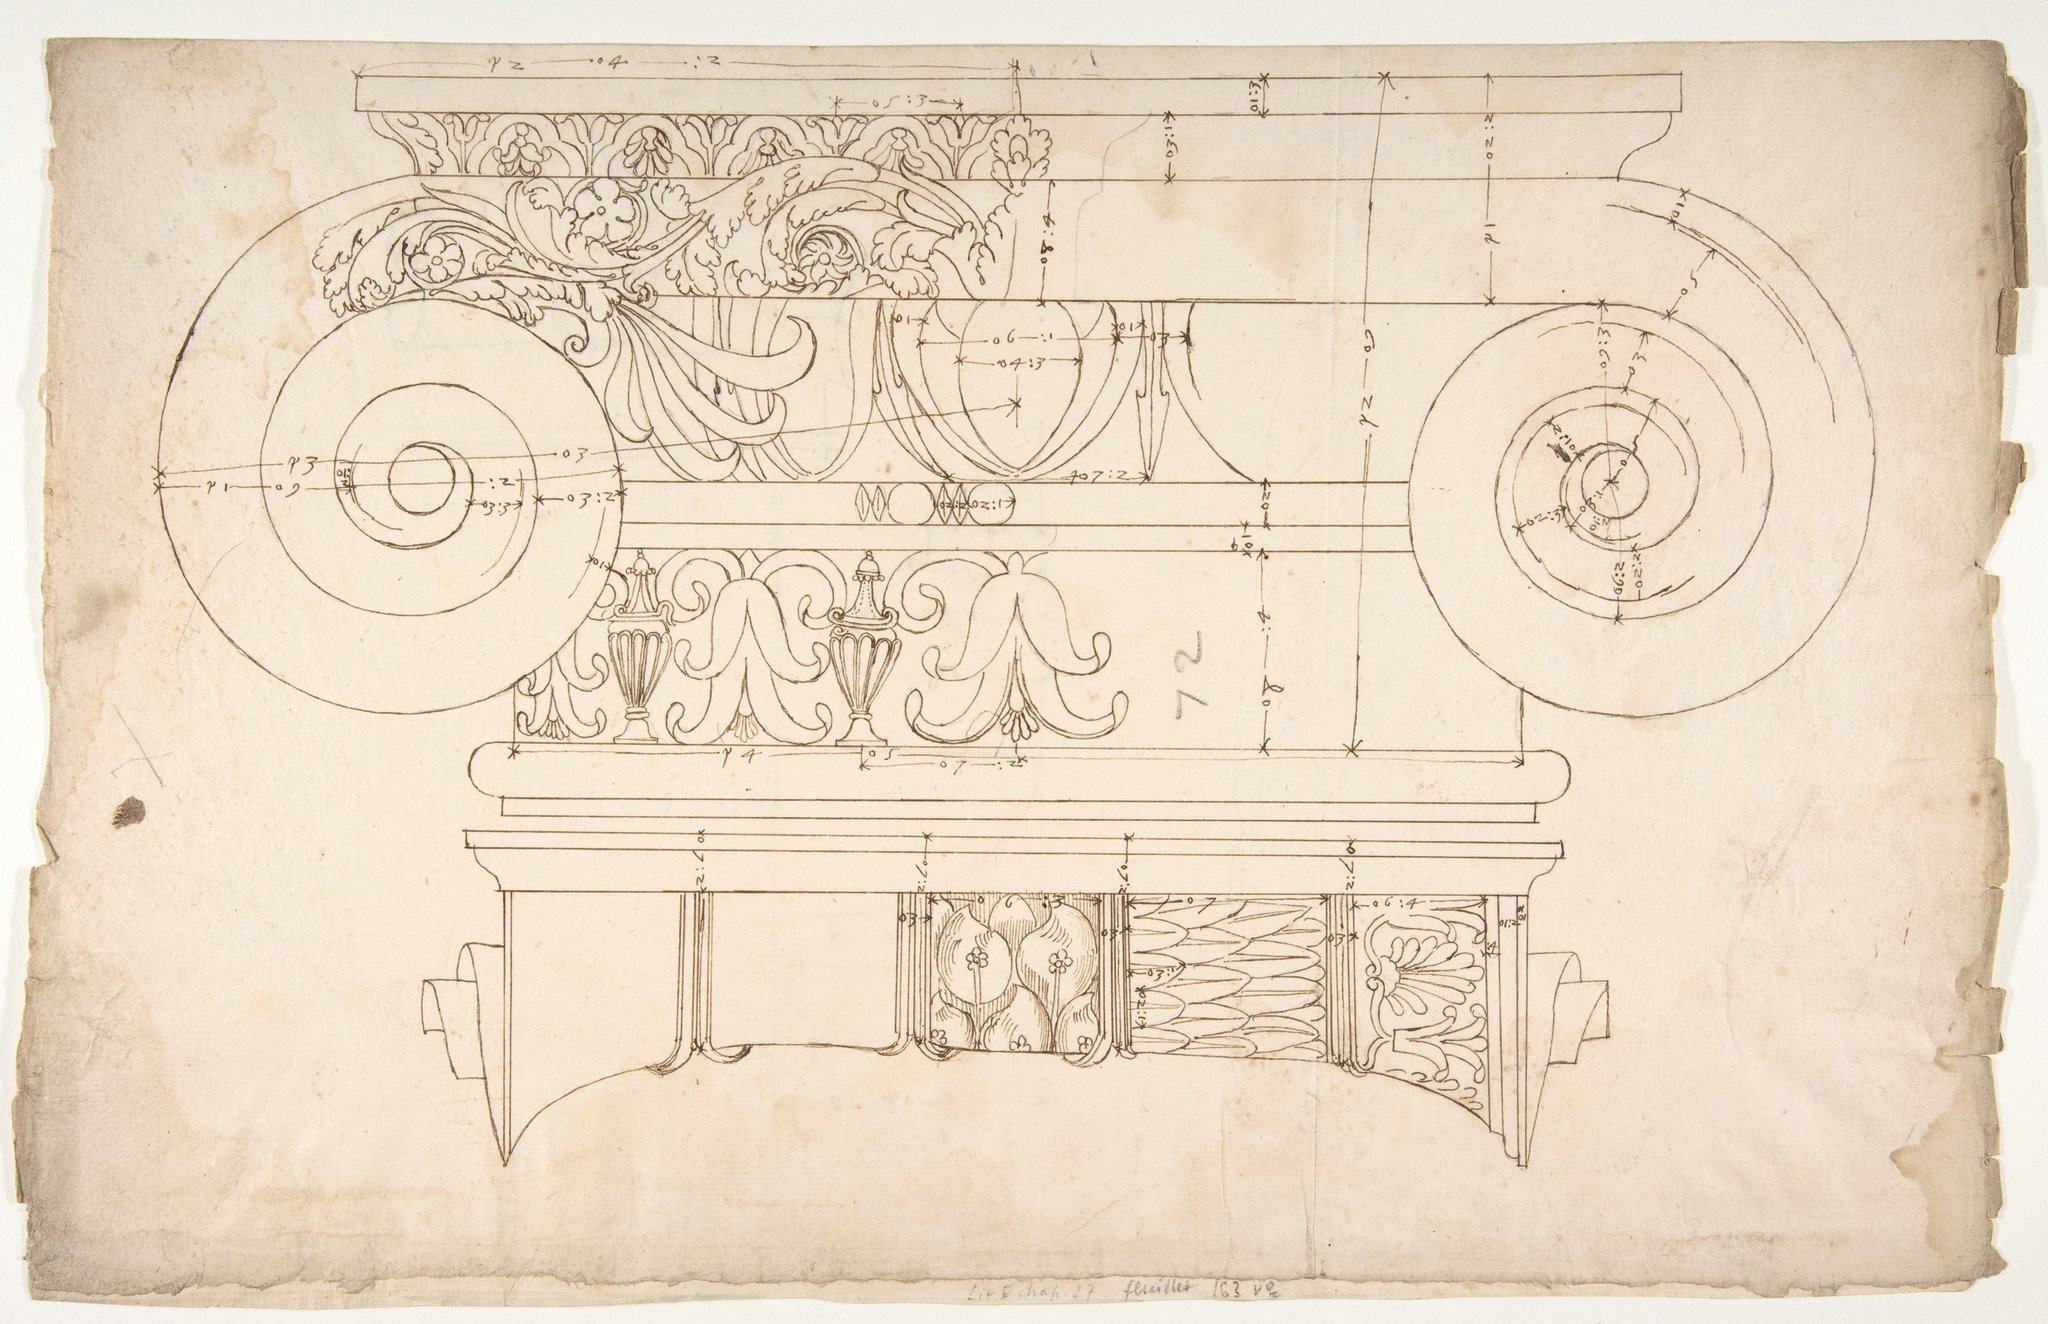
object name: collection ornament architecture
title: Unidentified, Ionic capital, elevation, front and side (recto) Unidentifed, Ionic capital, section, detail; Ionic capital, elevation, detail (verso)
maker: anonymous, french, 16th century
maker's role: draftsman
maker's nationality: french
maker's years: 1500-1600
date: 1540-1560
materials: chalk, ink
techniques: incising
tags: capitals